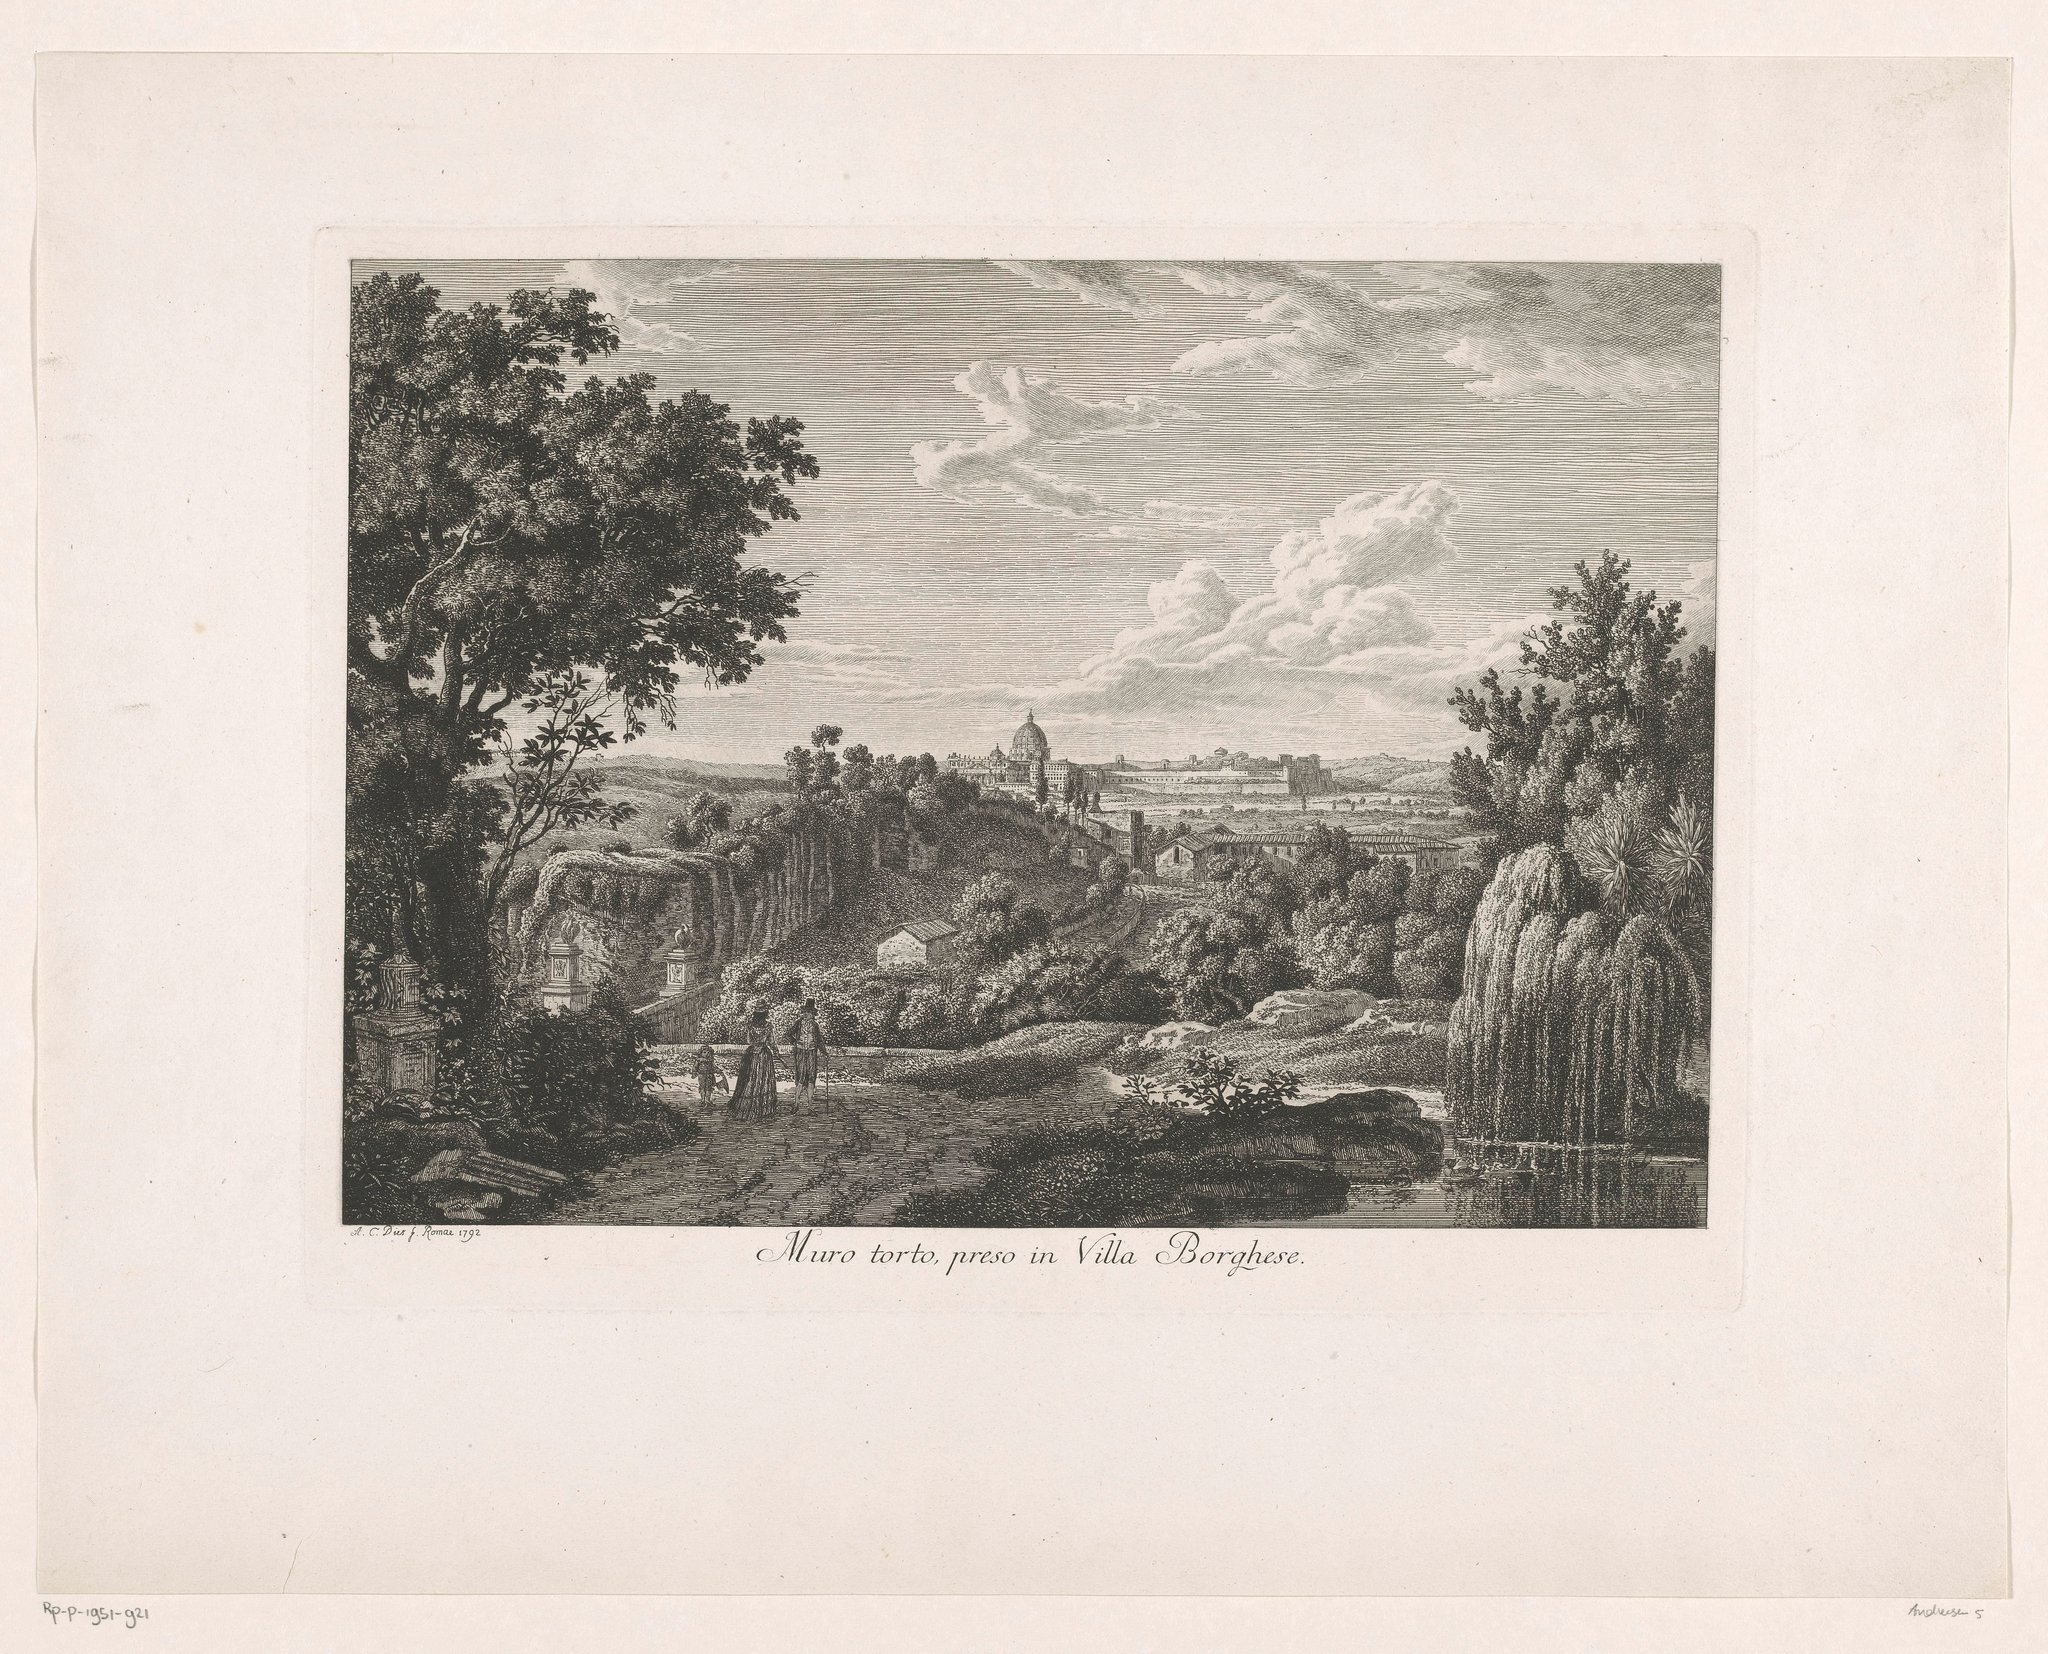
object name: print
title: Begroeide muur bij Villa Borghese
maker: albert christoph dies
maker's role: painter, print maker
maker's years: 1755-1822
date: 1792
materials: paper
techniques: etching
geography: rome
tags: city-view, and landscape with man-made constructions (+ city(-scape) with figures, staffage), village-walls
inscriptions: collector's mark: Lugt 2228